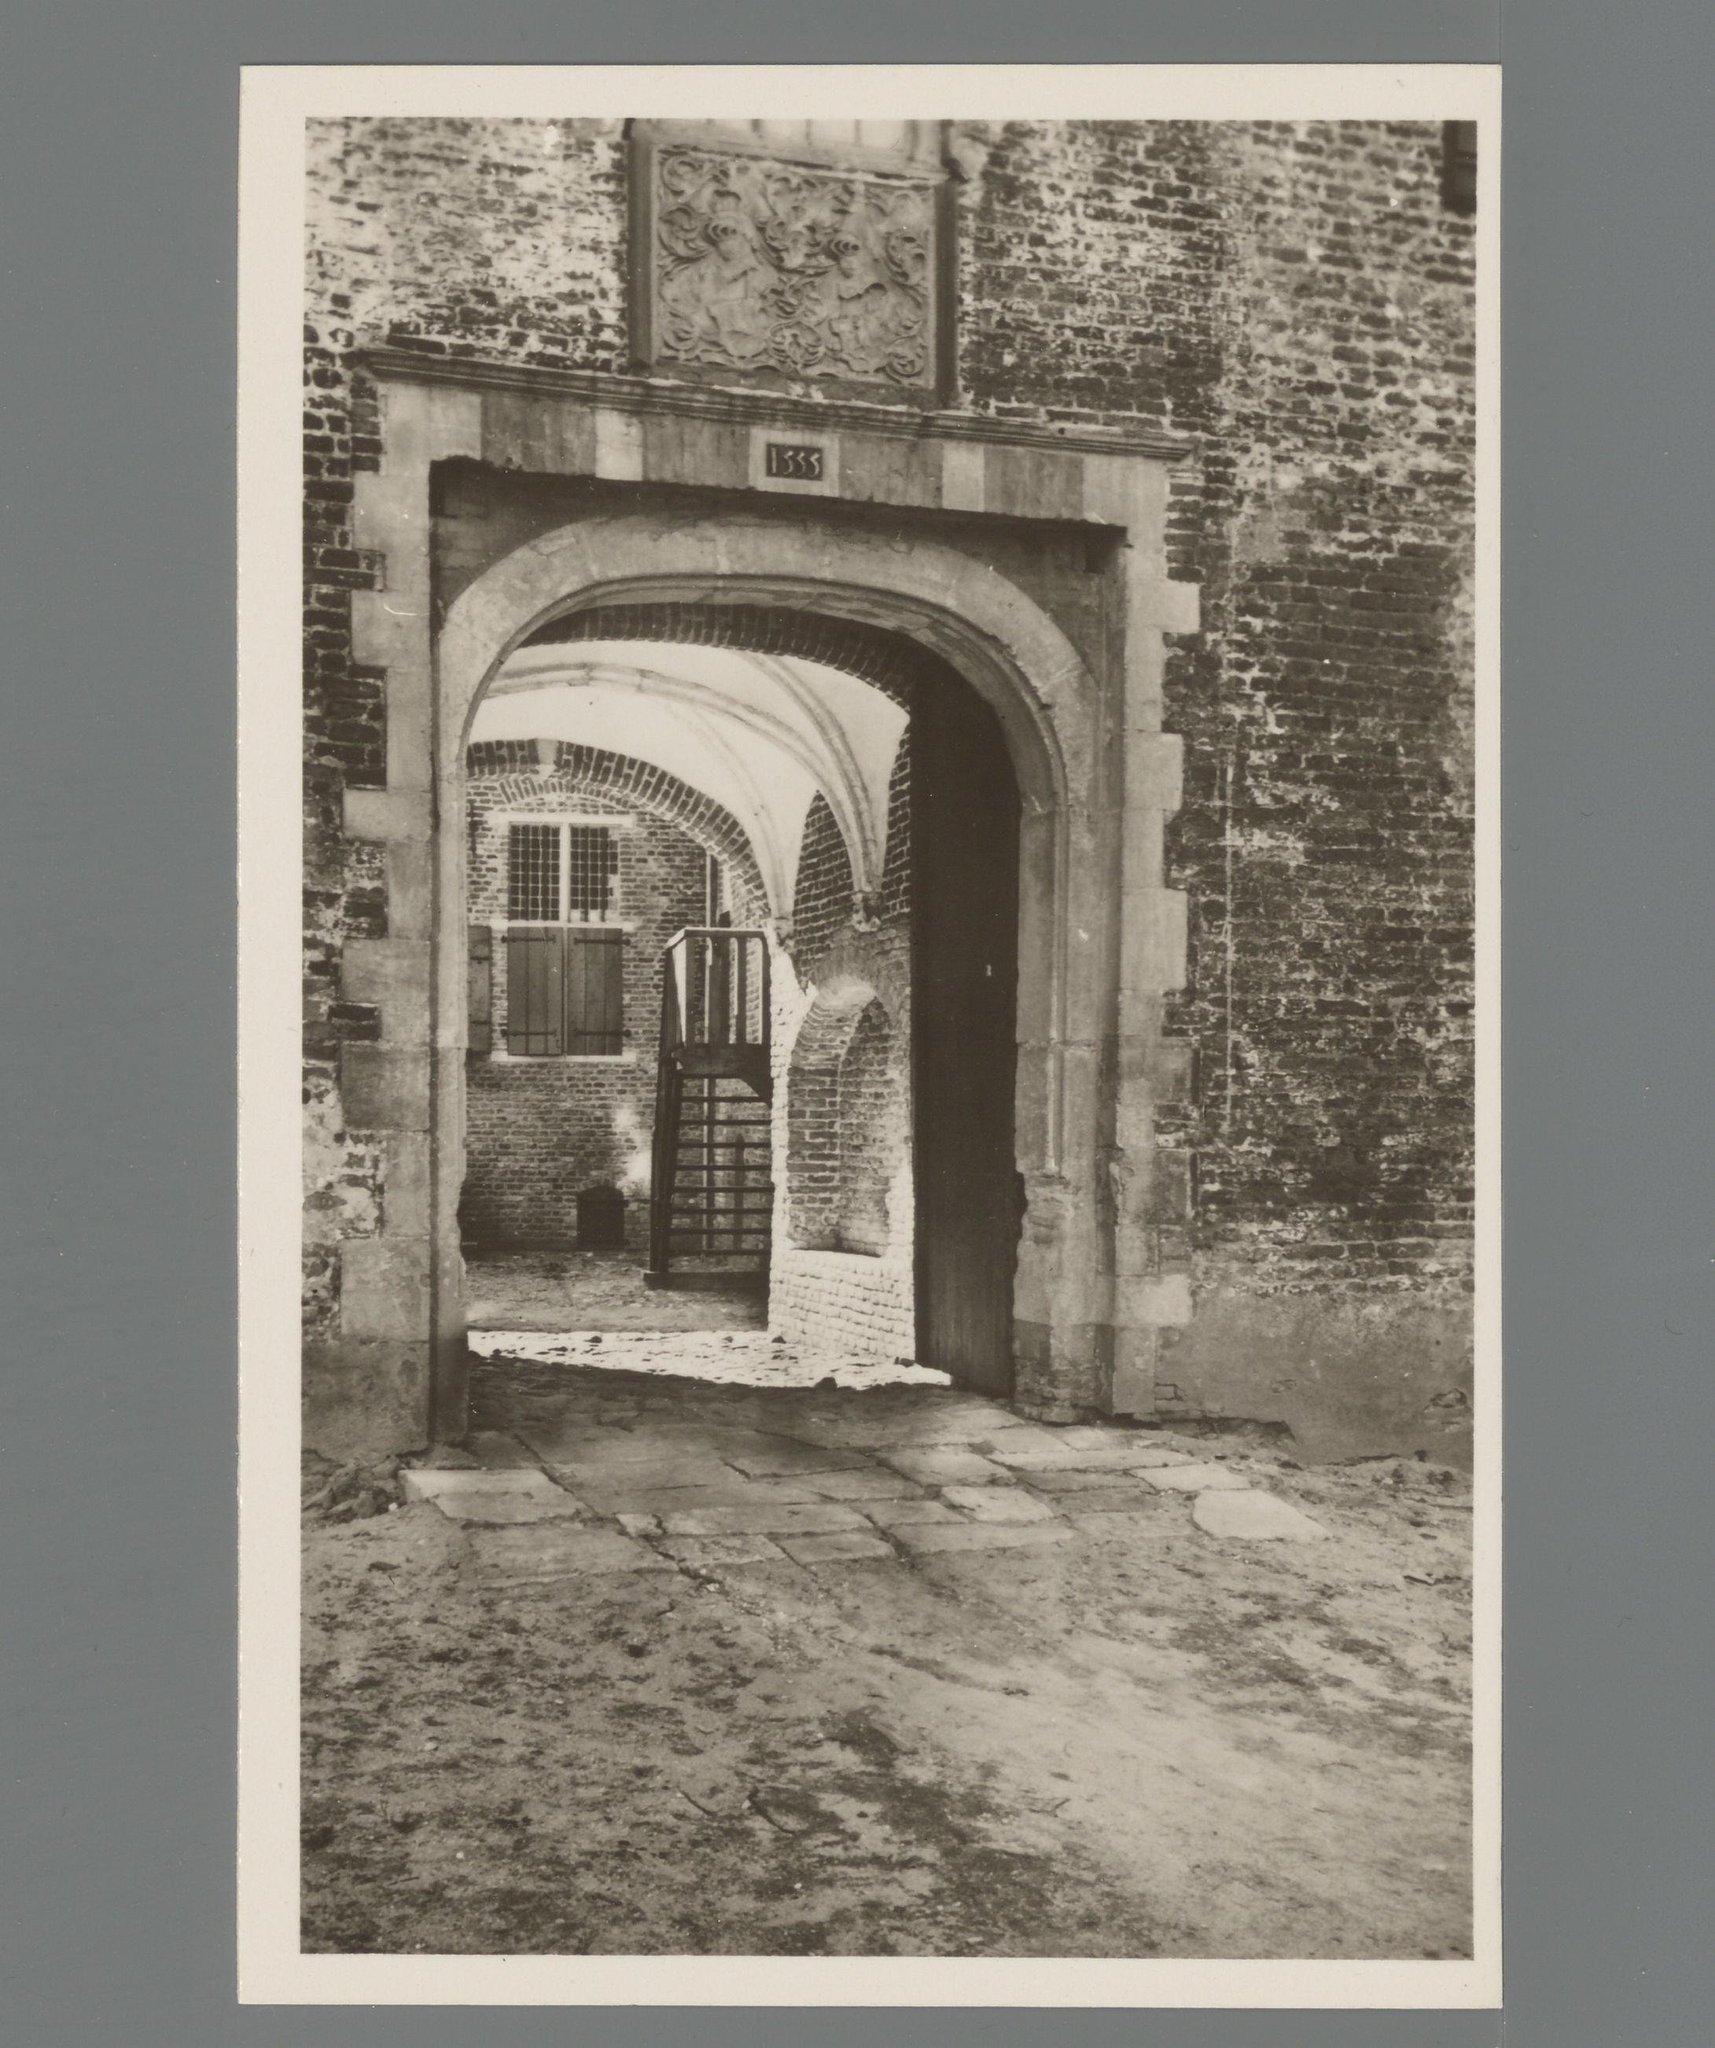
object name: ansichtkaart, prentbriefkaart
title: Kasteel Hernen (toegangspoort)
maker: george flipse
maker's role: fotograaf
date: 1908-1949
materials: paper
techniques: gelatin silver print, writing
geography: hernen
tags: castle, gate, entrance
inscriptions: date